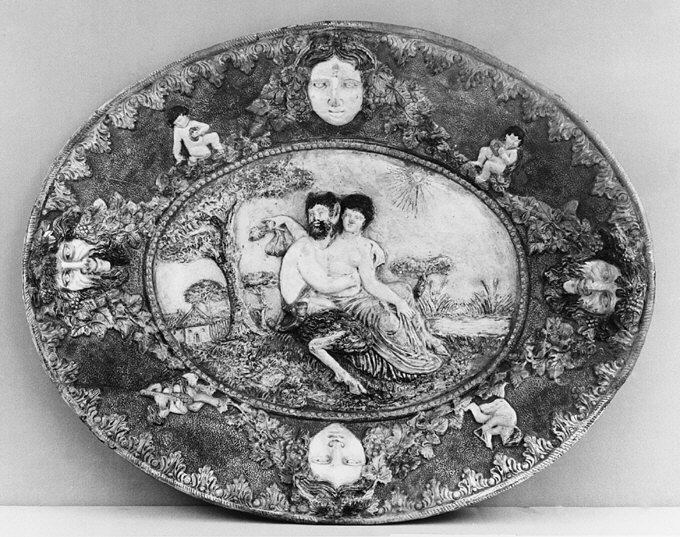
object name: plateau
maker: bernard palissy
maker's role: maker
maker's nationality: french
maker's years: 1510-1590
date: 1801-1900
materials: earthenware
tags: faces,fauns